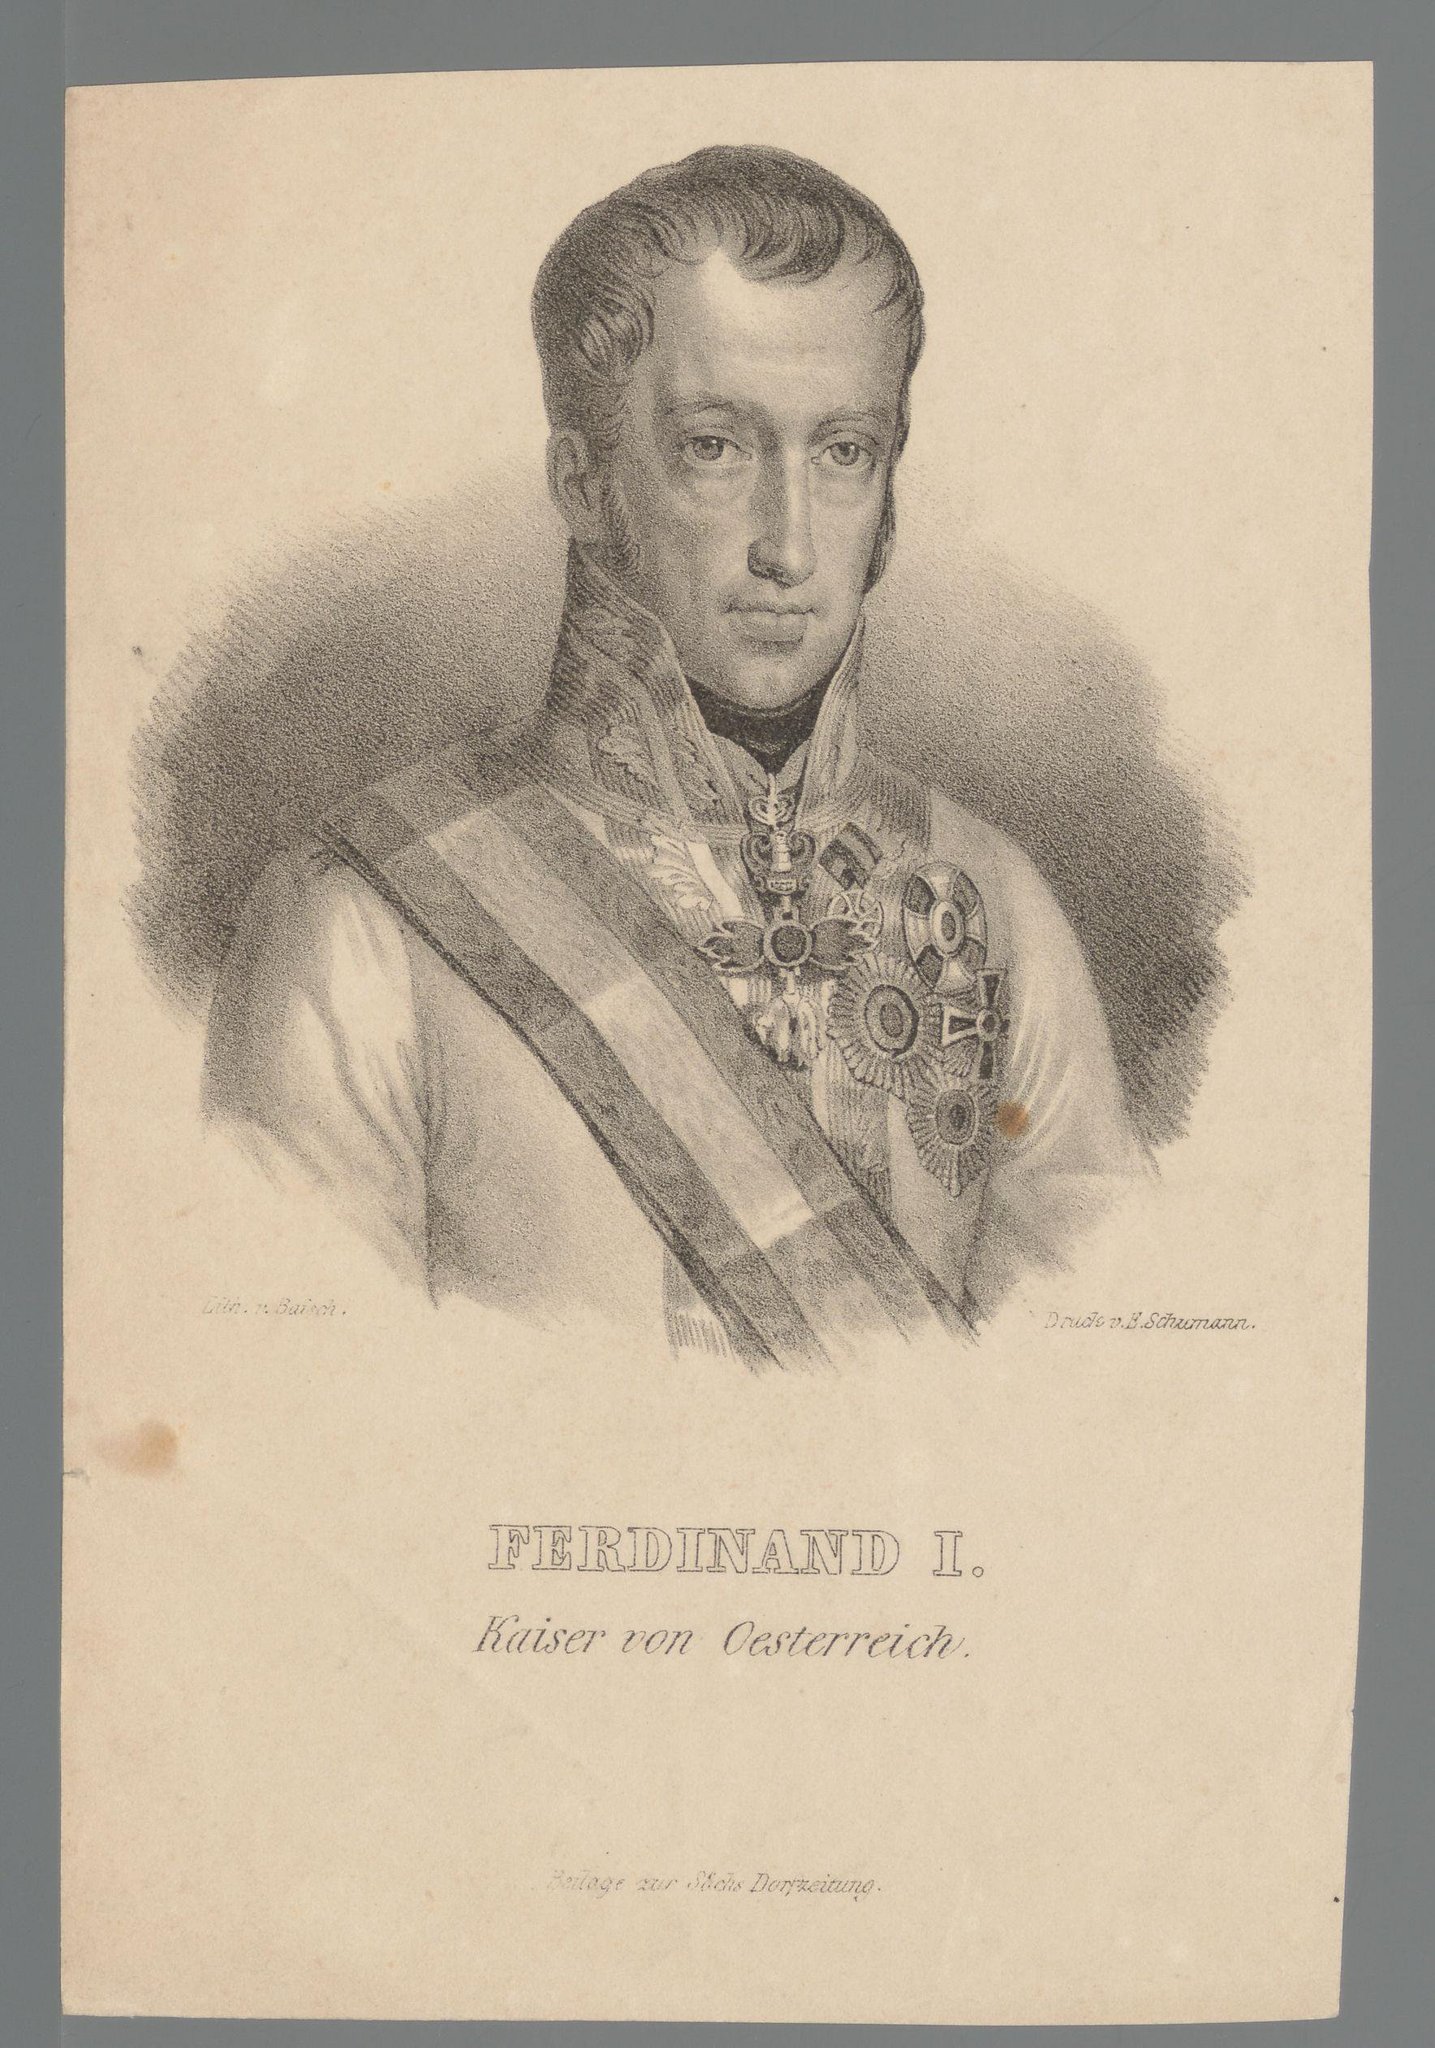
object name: print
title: Ferdinand I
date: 1815-1864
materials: paper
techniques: lithograph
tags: prague, ferdinand i (keizer van oostenrijk), historical persons, emperor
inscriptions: collector's mark: Lugt 2228